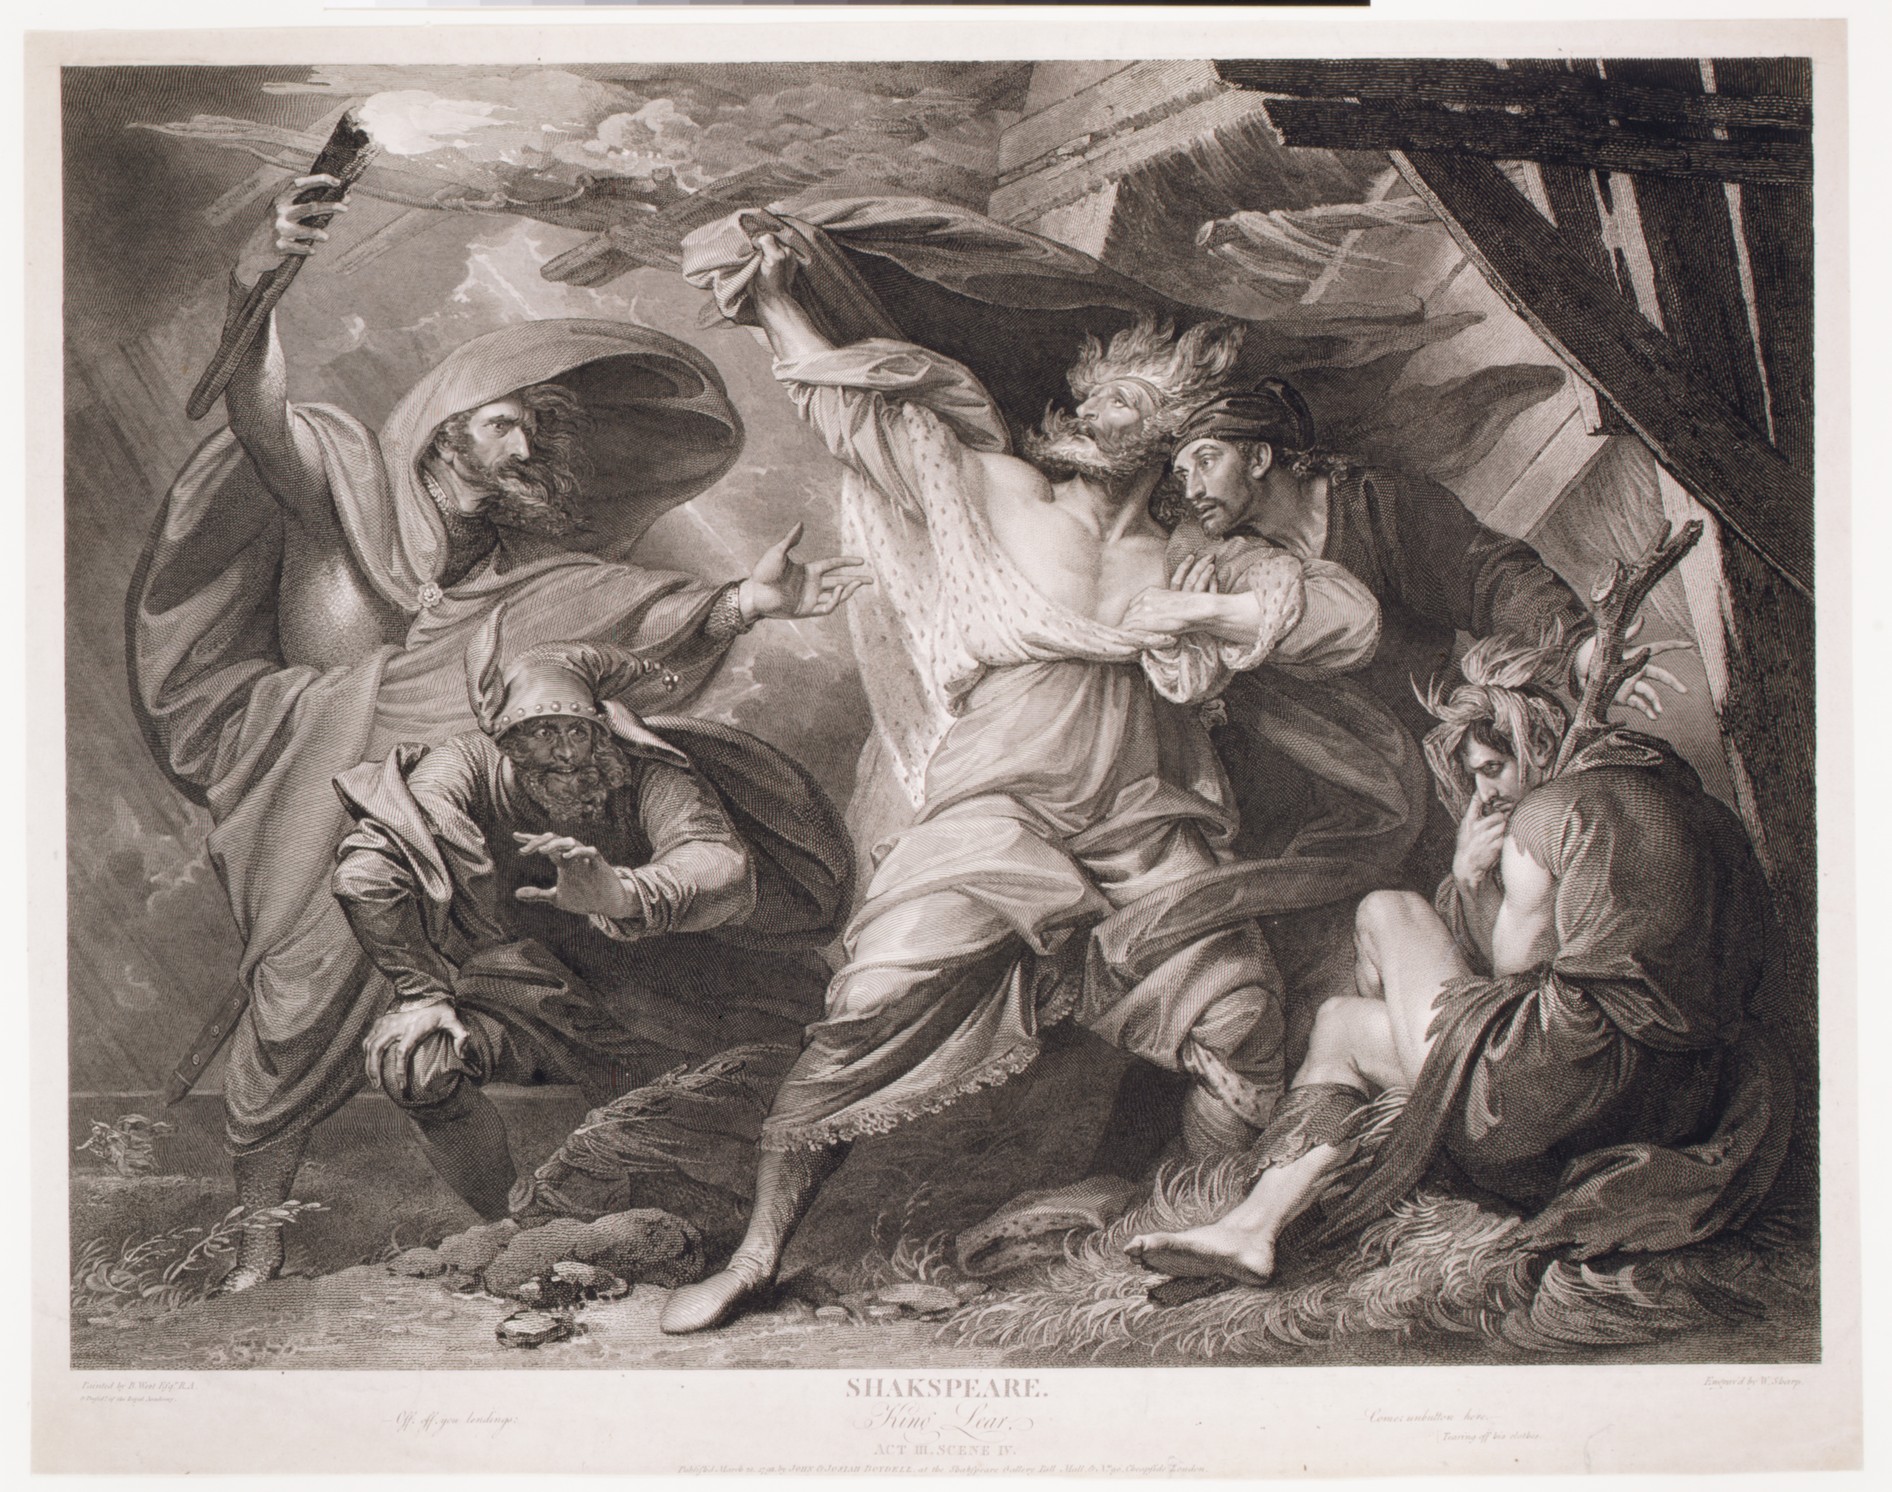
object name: print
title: "Off, off, you lendings–Come unbutton here" (Shakespeare, King Lear, Act 3, Scene 4)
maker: william sharp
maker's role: artist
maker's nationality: british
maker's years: 1749-1824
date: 1793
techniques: engraving, etching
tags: shakespeare,men